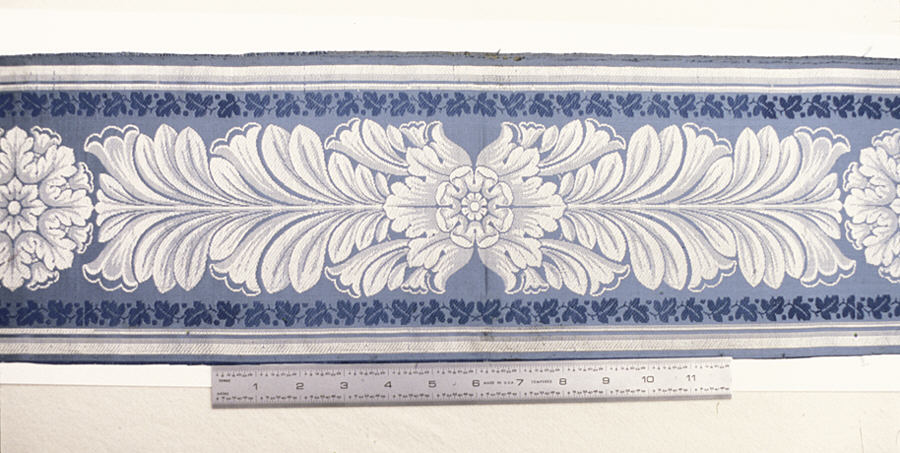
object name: piece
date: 1801-1833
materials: silk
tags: flowers